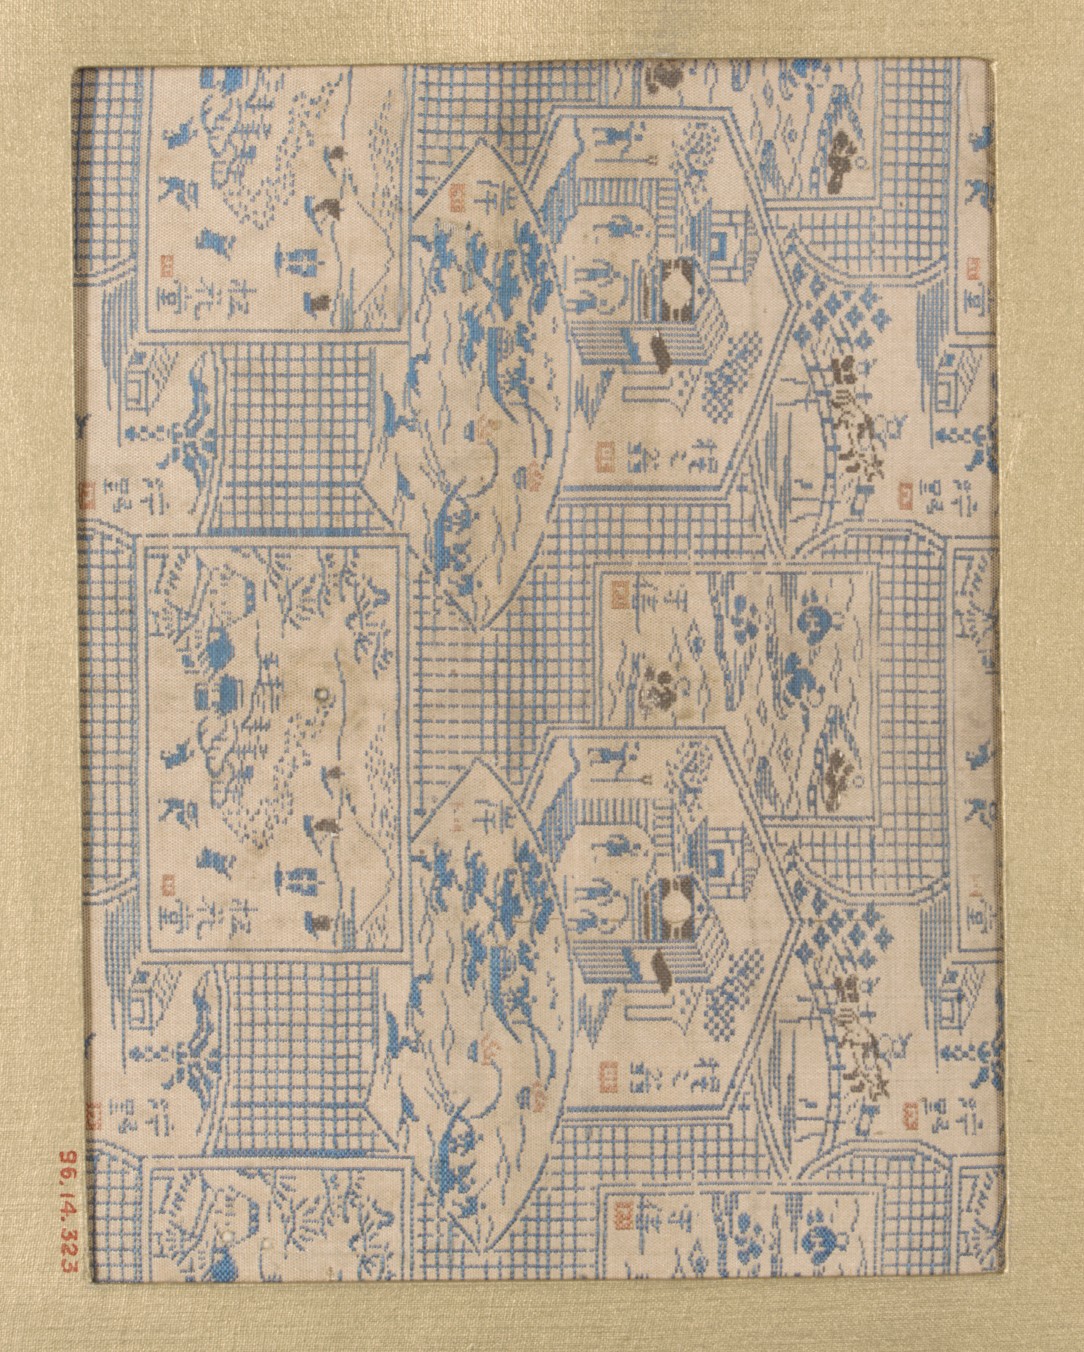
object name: piece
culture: japanese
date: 1701-1900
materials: silk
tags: human figures,boats